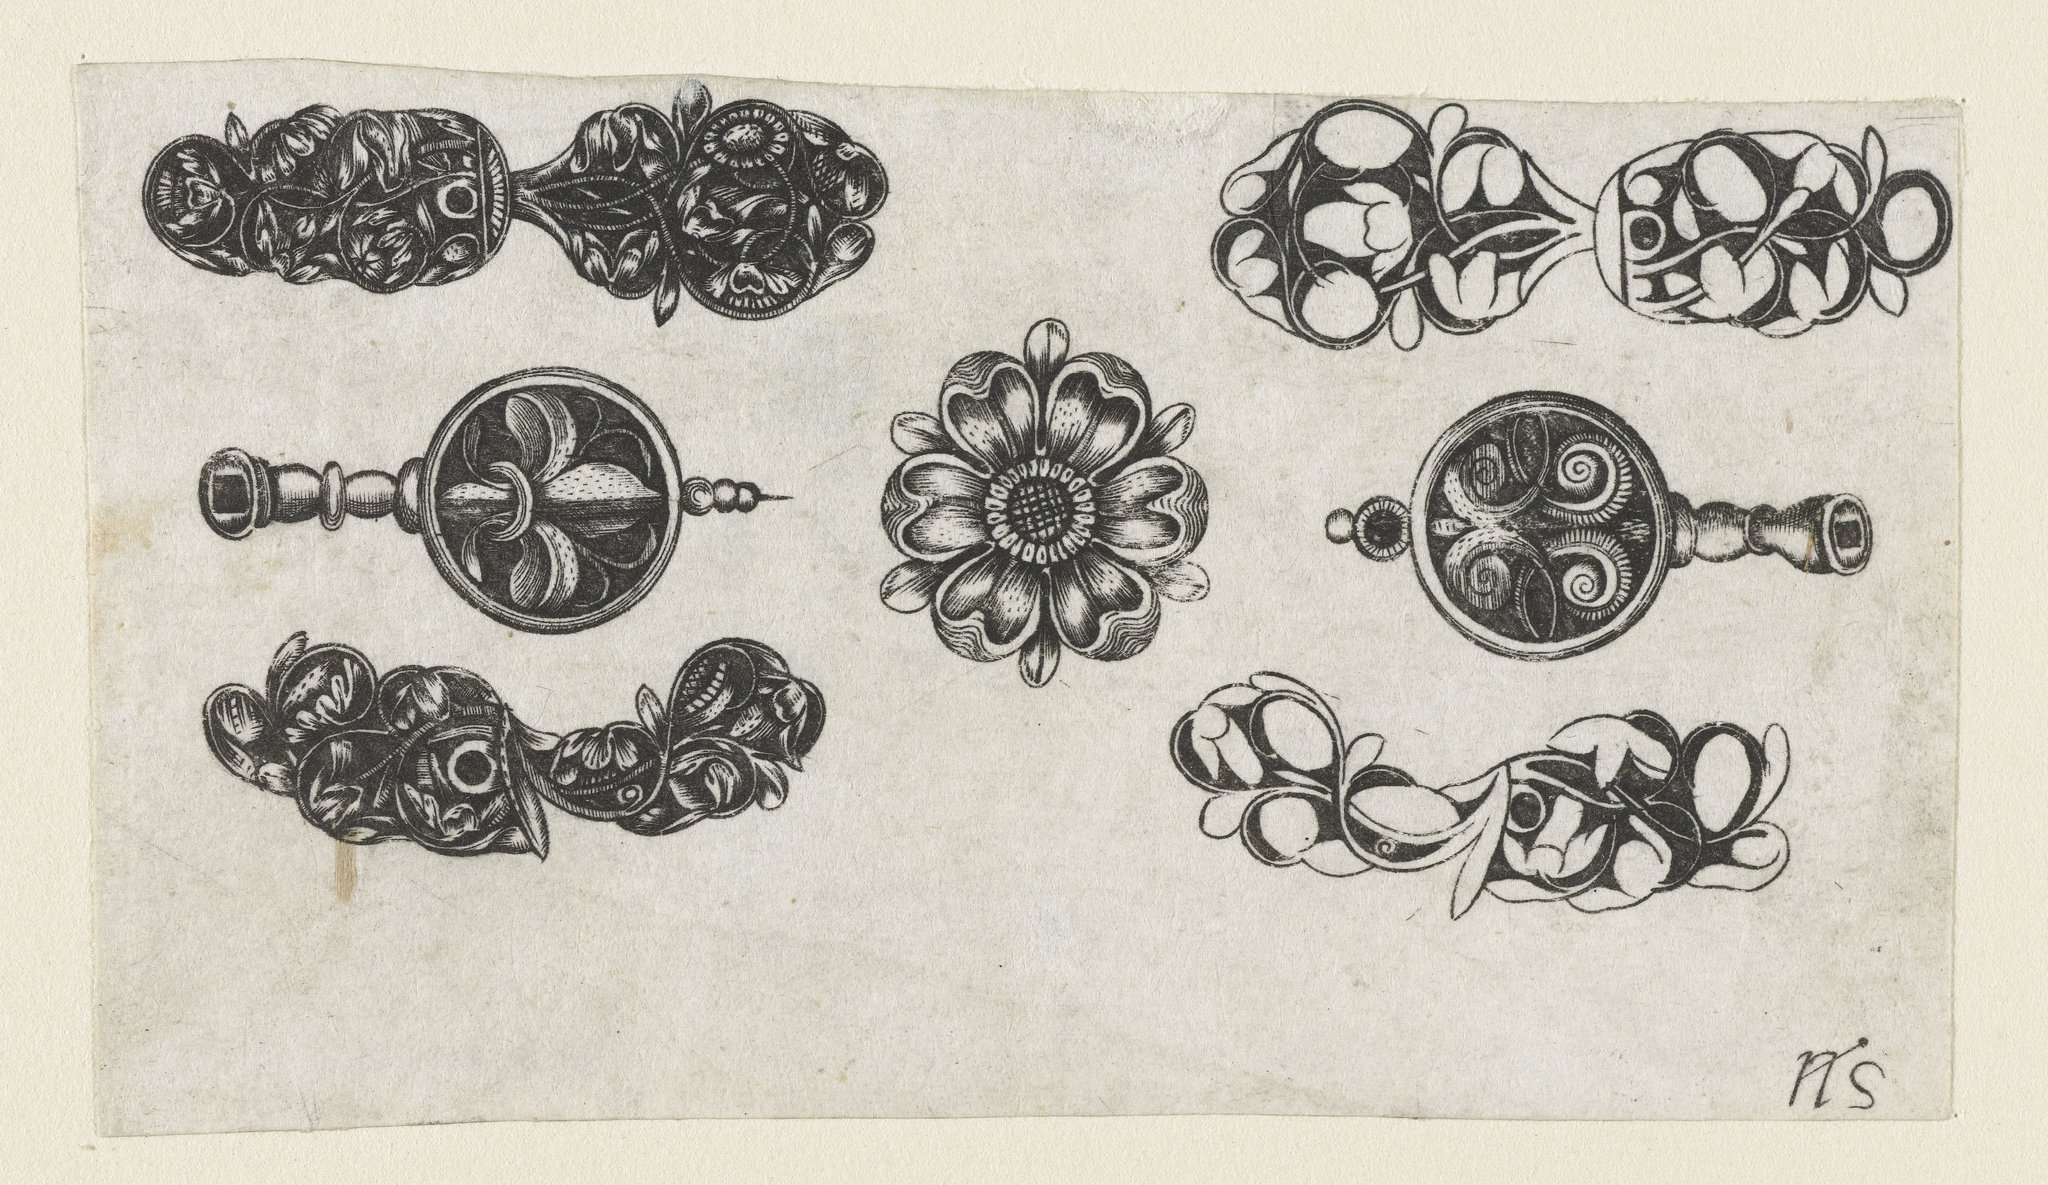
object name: ornament print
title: Horlogesleutels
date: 1600-1699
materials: paper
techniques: engraving, etching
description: Horlogesleutels of zgn 'Spindelkloben' gedecoreerd met bladranken en bloemen. Rechtsonder staat N° 2 (2 of een omgekeerde 5). Uit serie van 6 bladen.